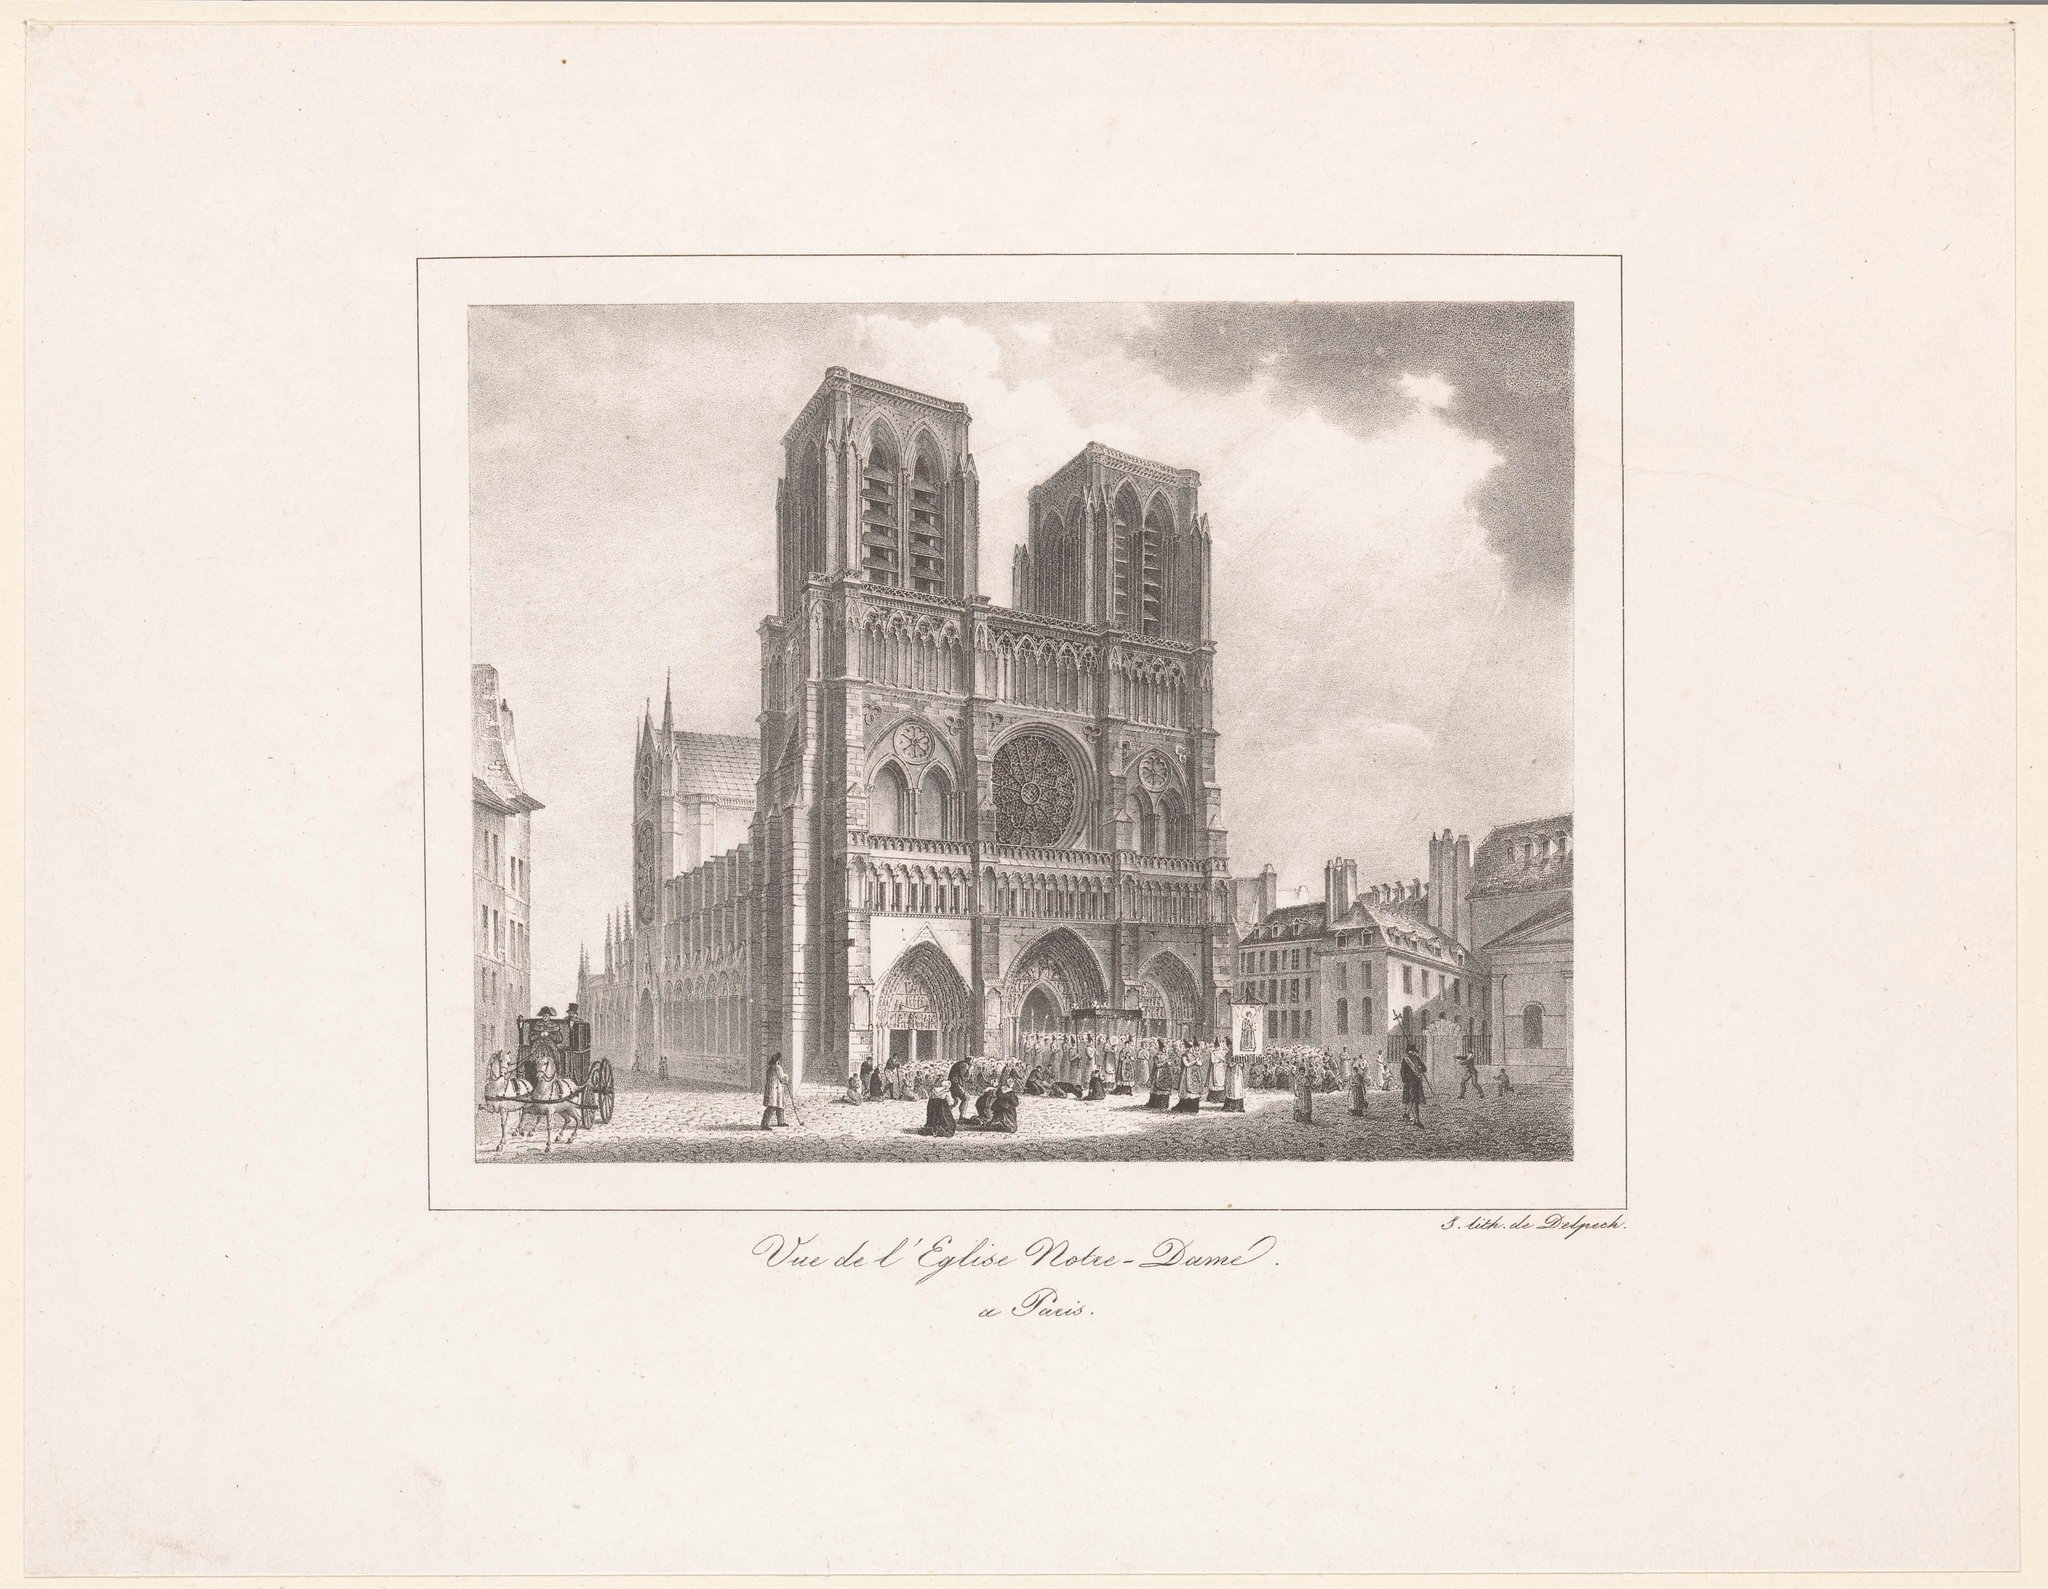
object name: print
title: Kleine gezichten van Parijs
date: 1820-1821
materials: paper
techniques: lithograph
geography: paris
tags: church (exterior), procession ~ christian religion, paris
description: De serie waar deze prent deel van uit maakt, bestaat waarschijnlijk uit dertig prenten.